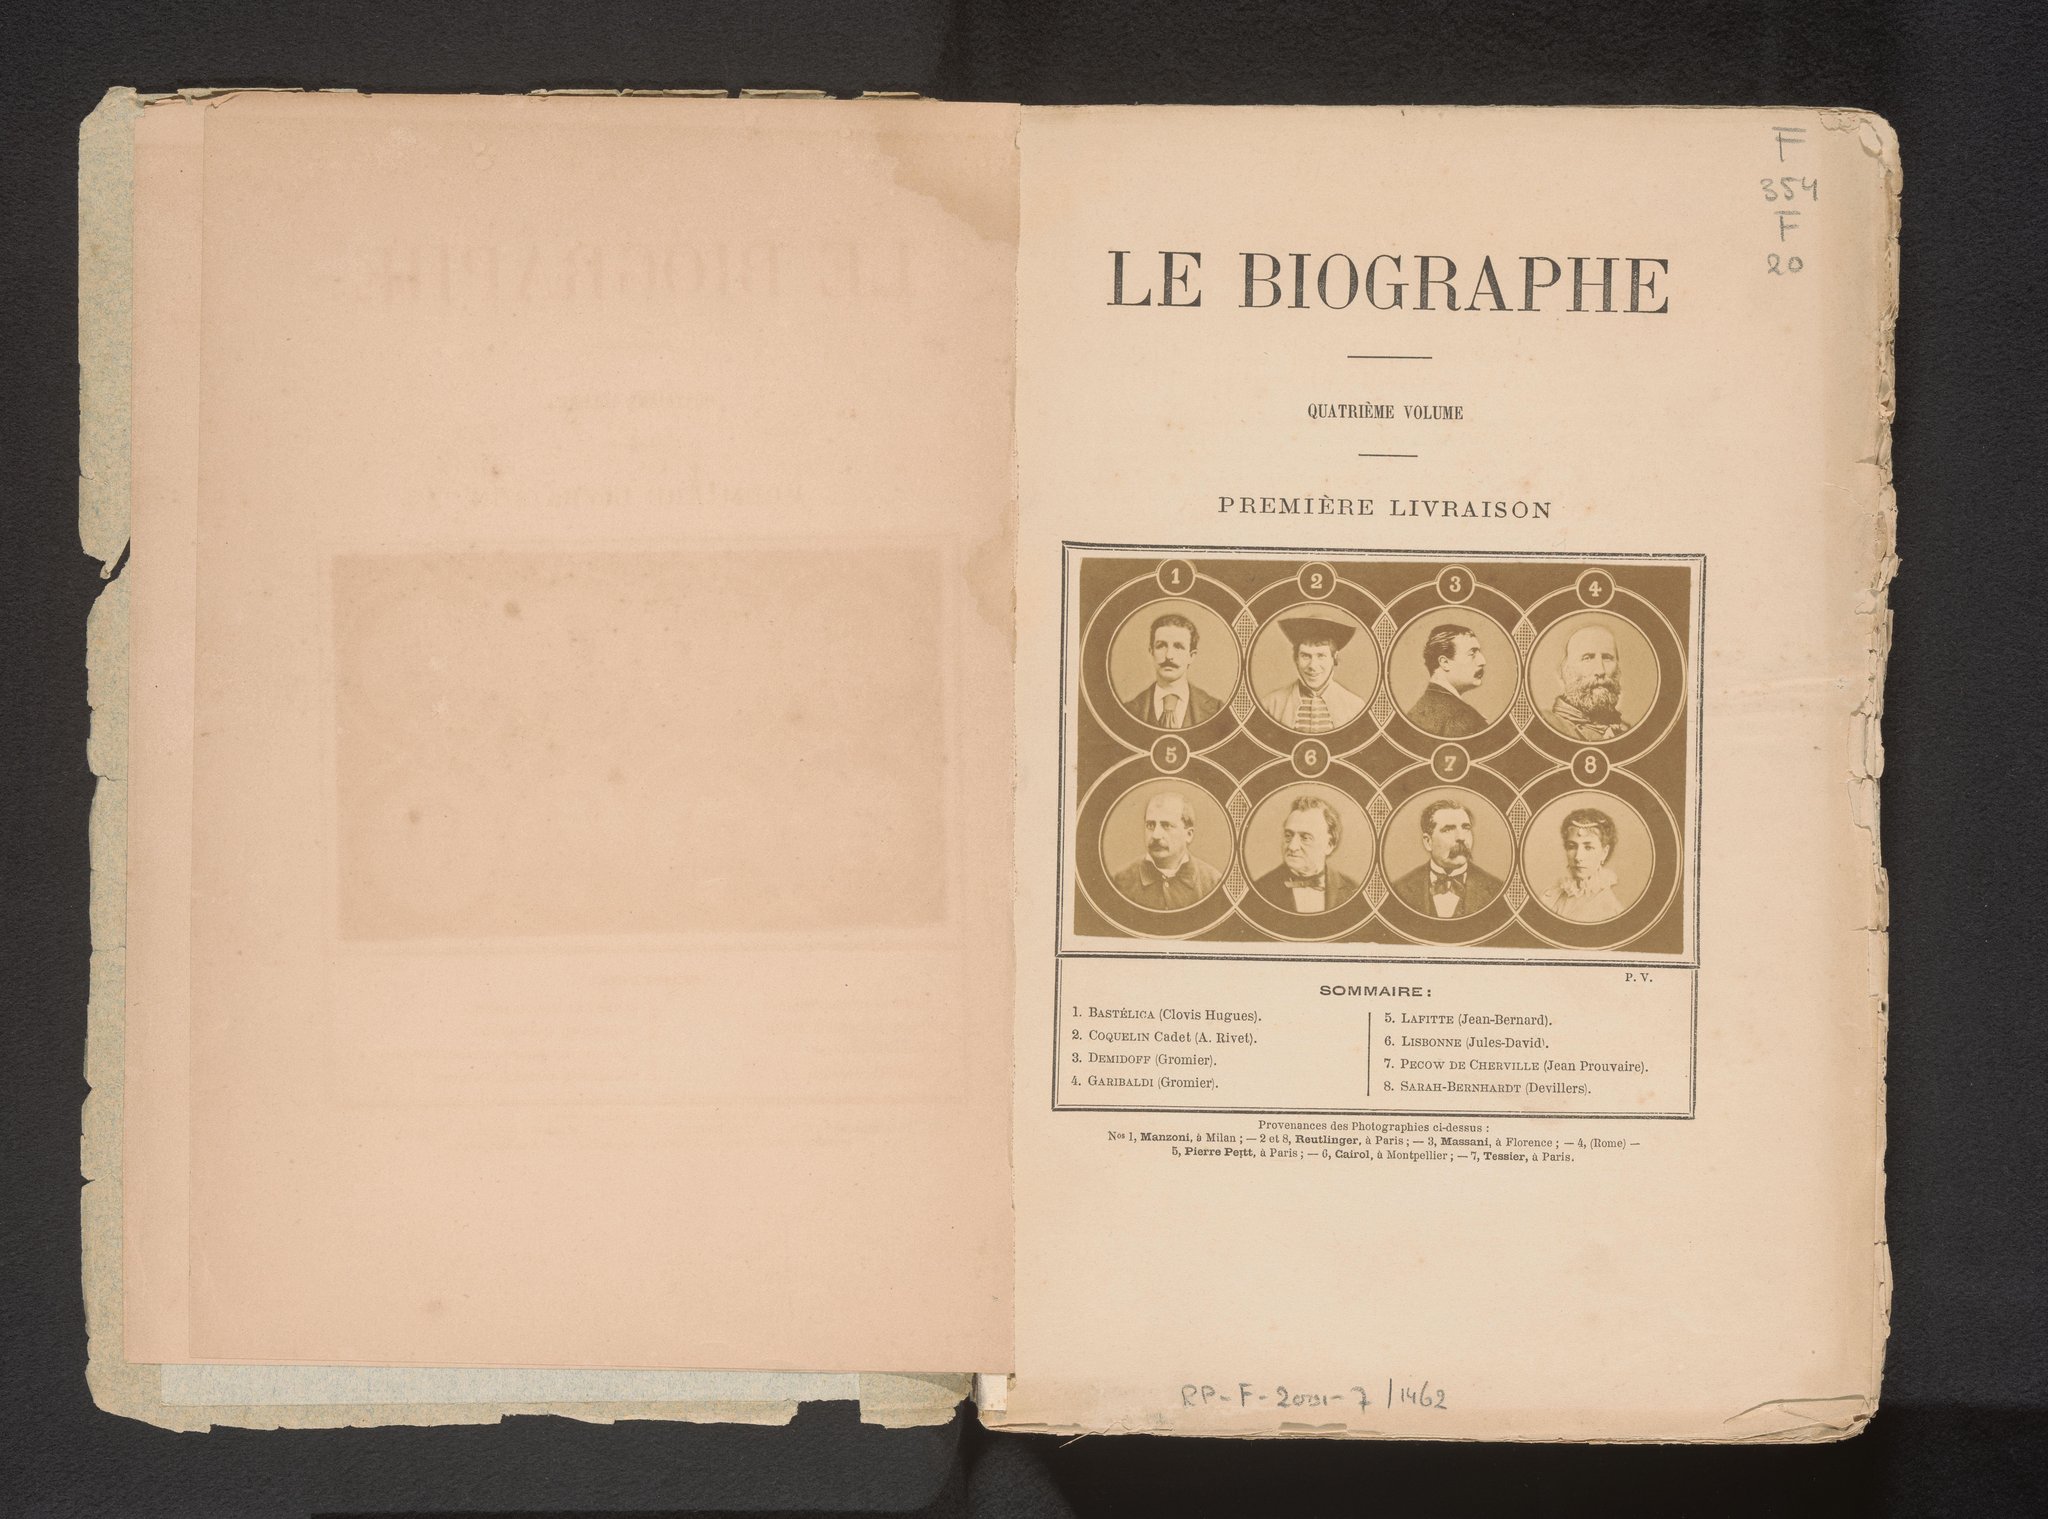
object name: book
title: Le biographe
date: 1880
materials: cardboard, paper, photographic support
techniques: albumen print, printing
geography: paris